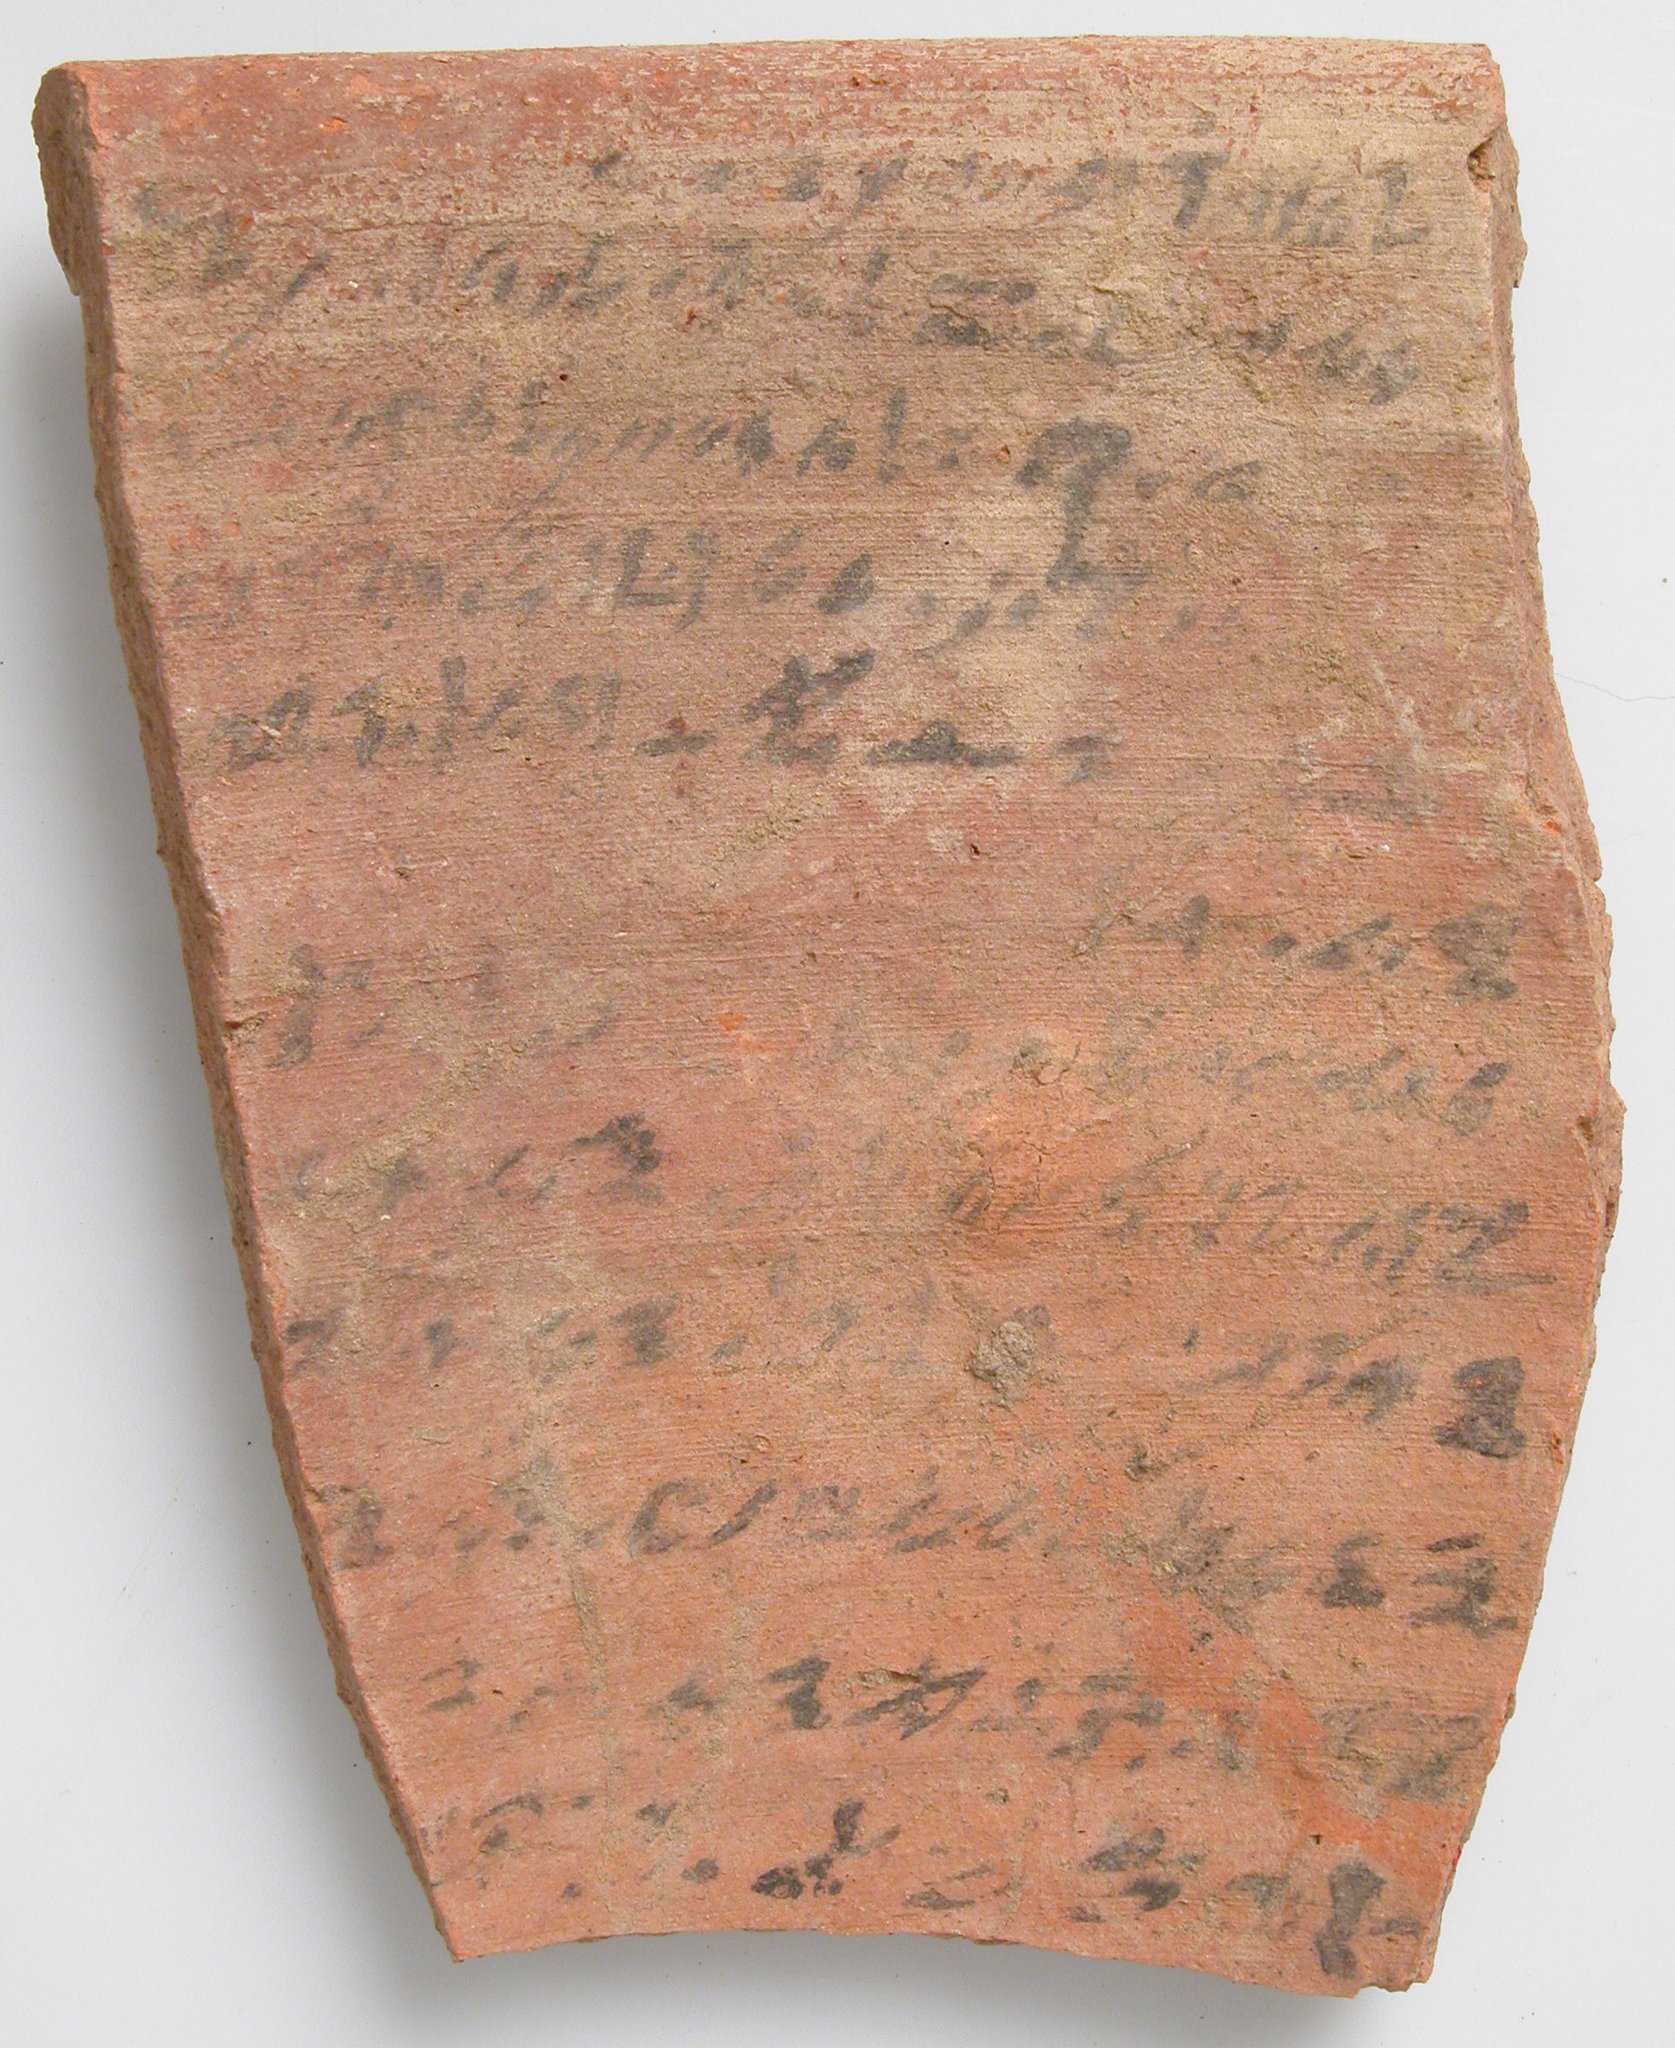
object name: ostracon, hieratic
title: Ostracon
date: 595-530 BCE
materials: ink, pottery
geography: egypt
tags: hieratic